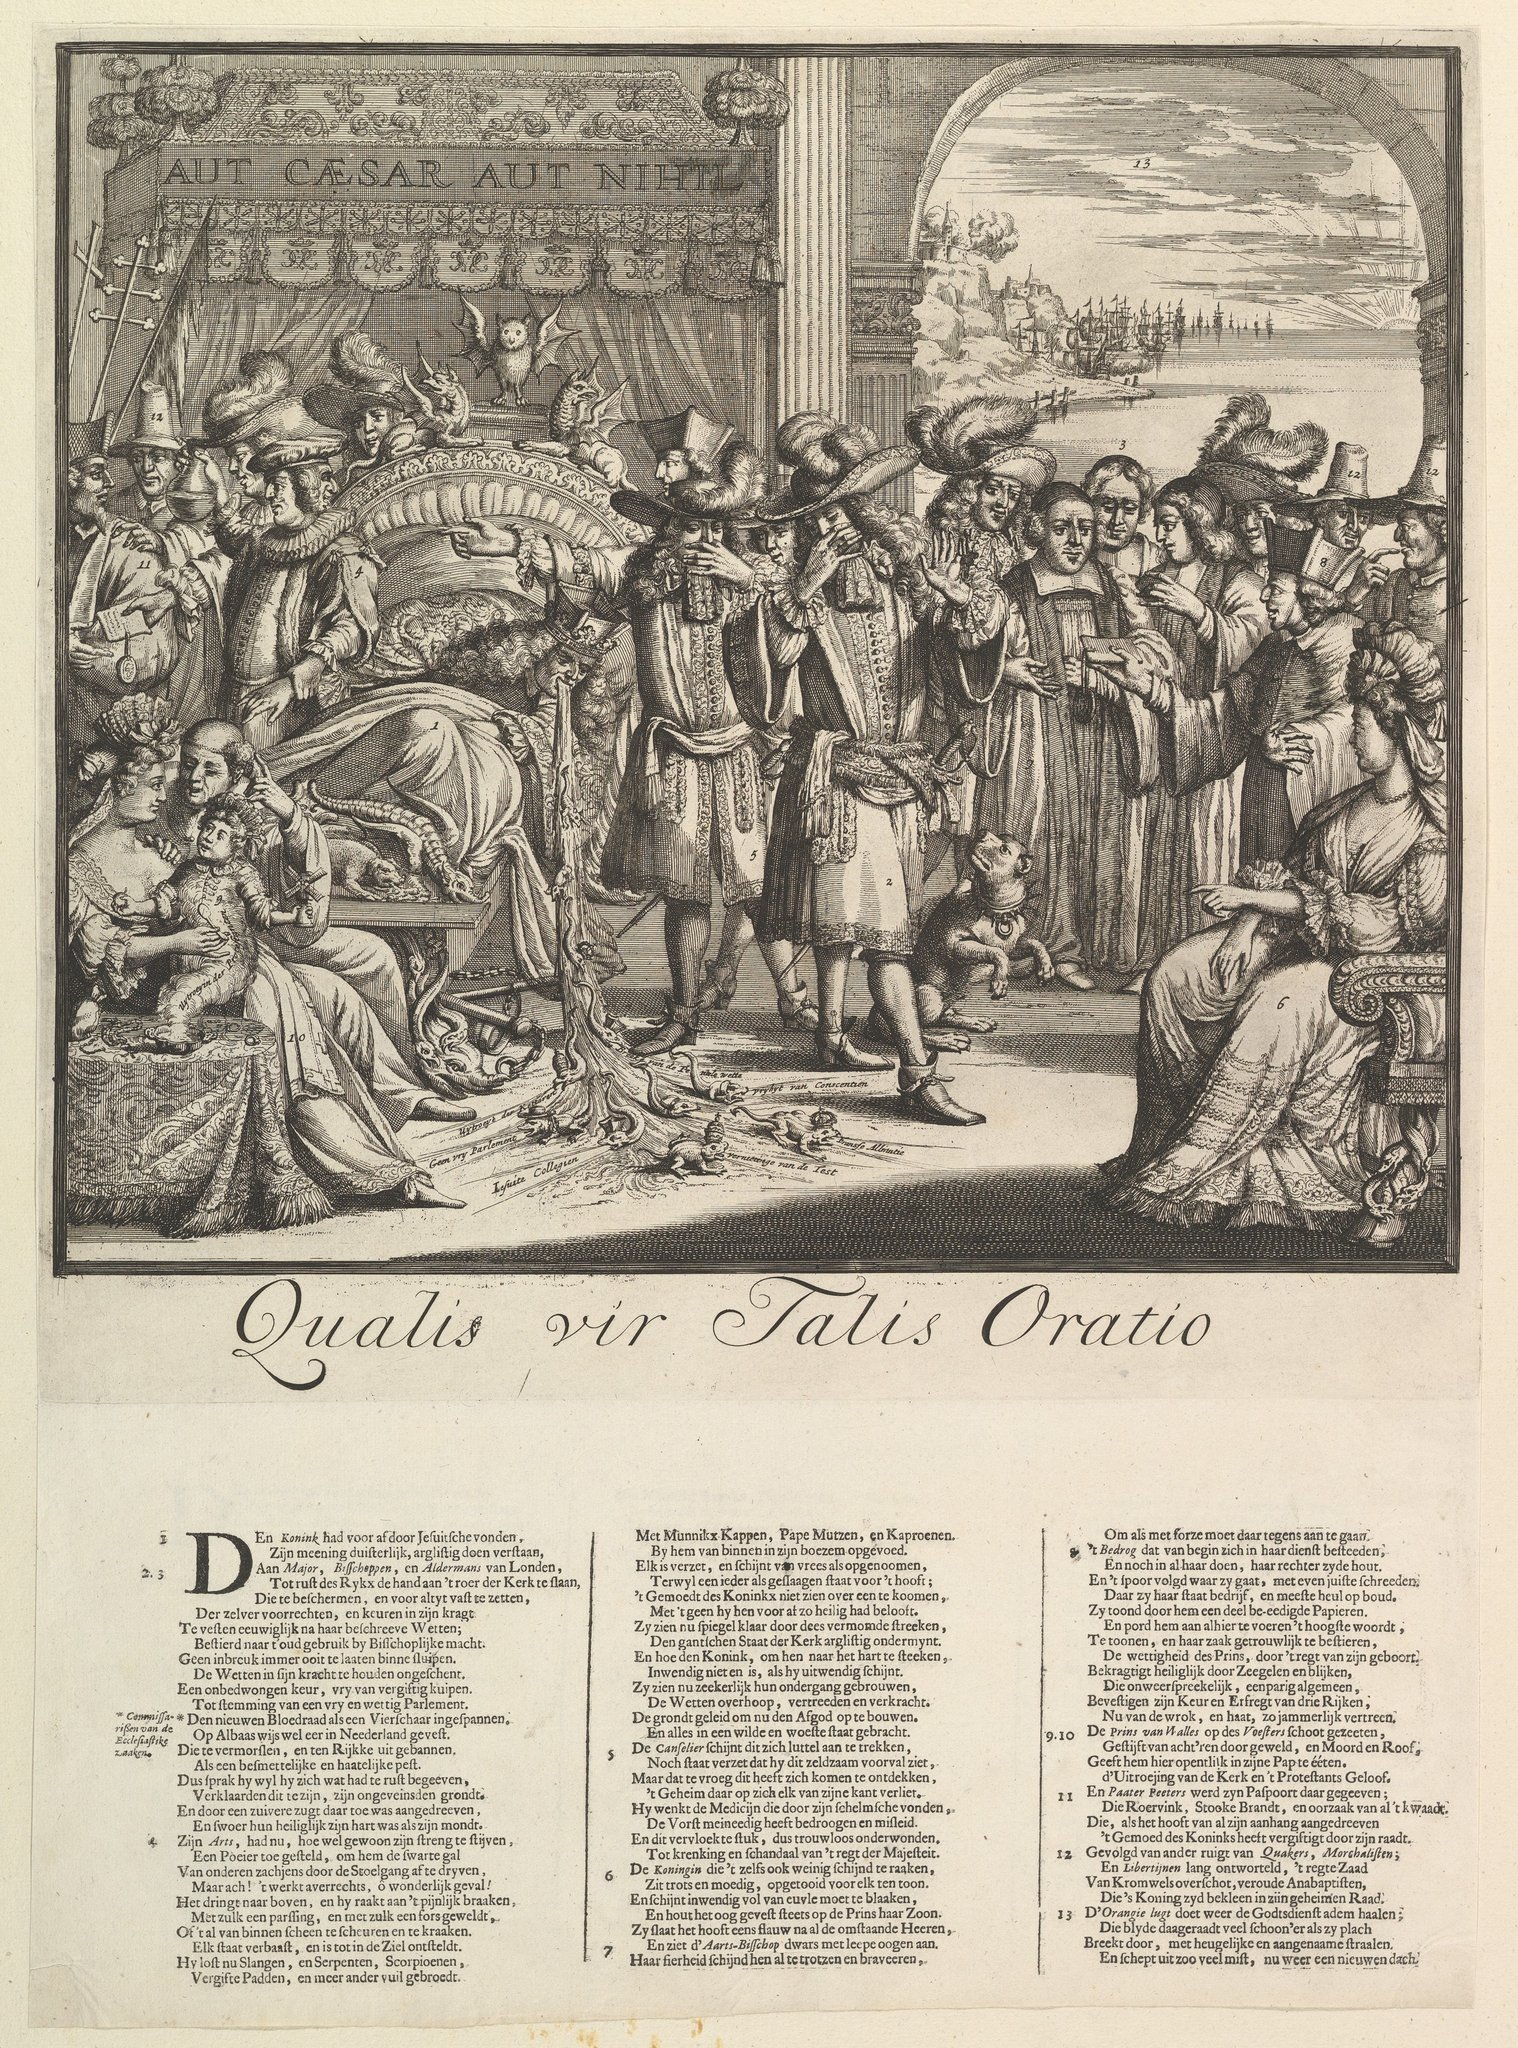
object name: print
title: Qualis vir Talis Oratio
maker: romeyn de hooghe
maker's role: artist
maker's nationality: dutch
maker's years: 1645-1708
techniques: etching, letterpress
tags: satire,kings,men,women,dogs